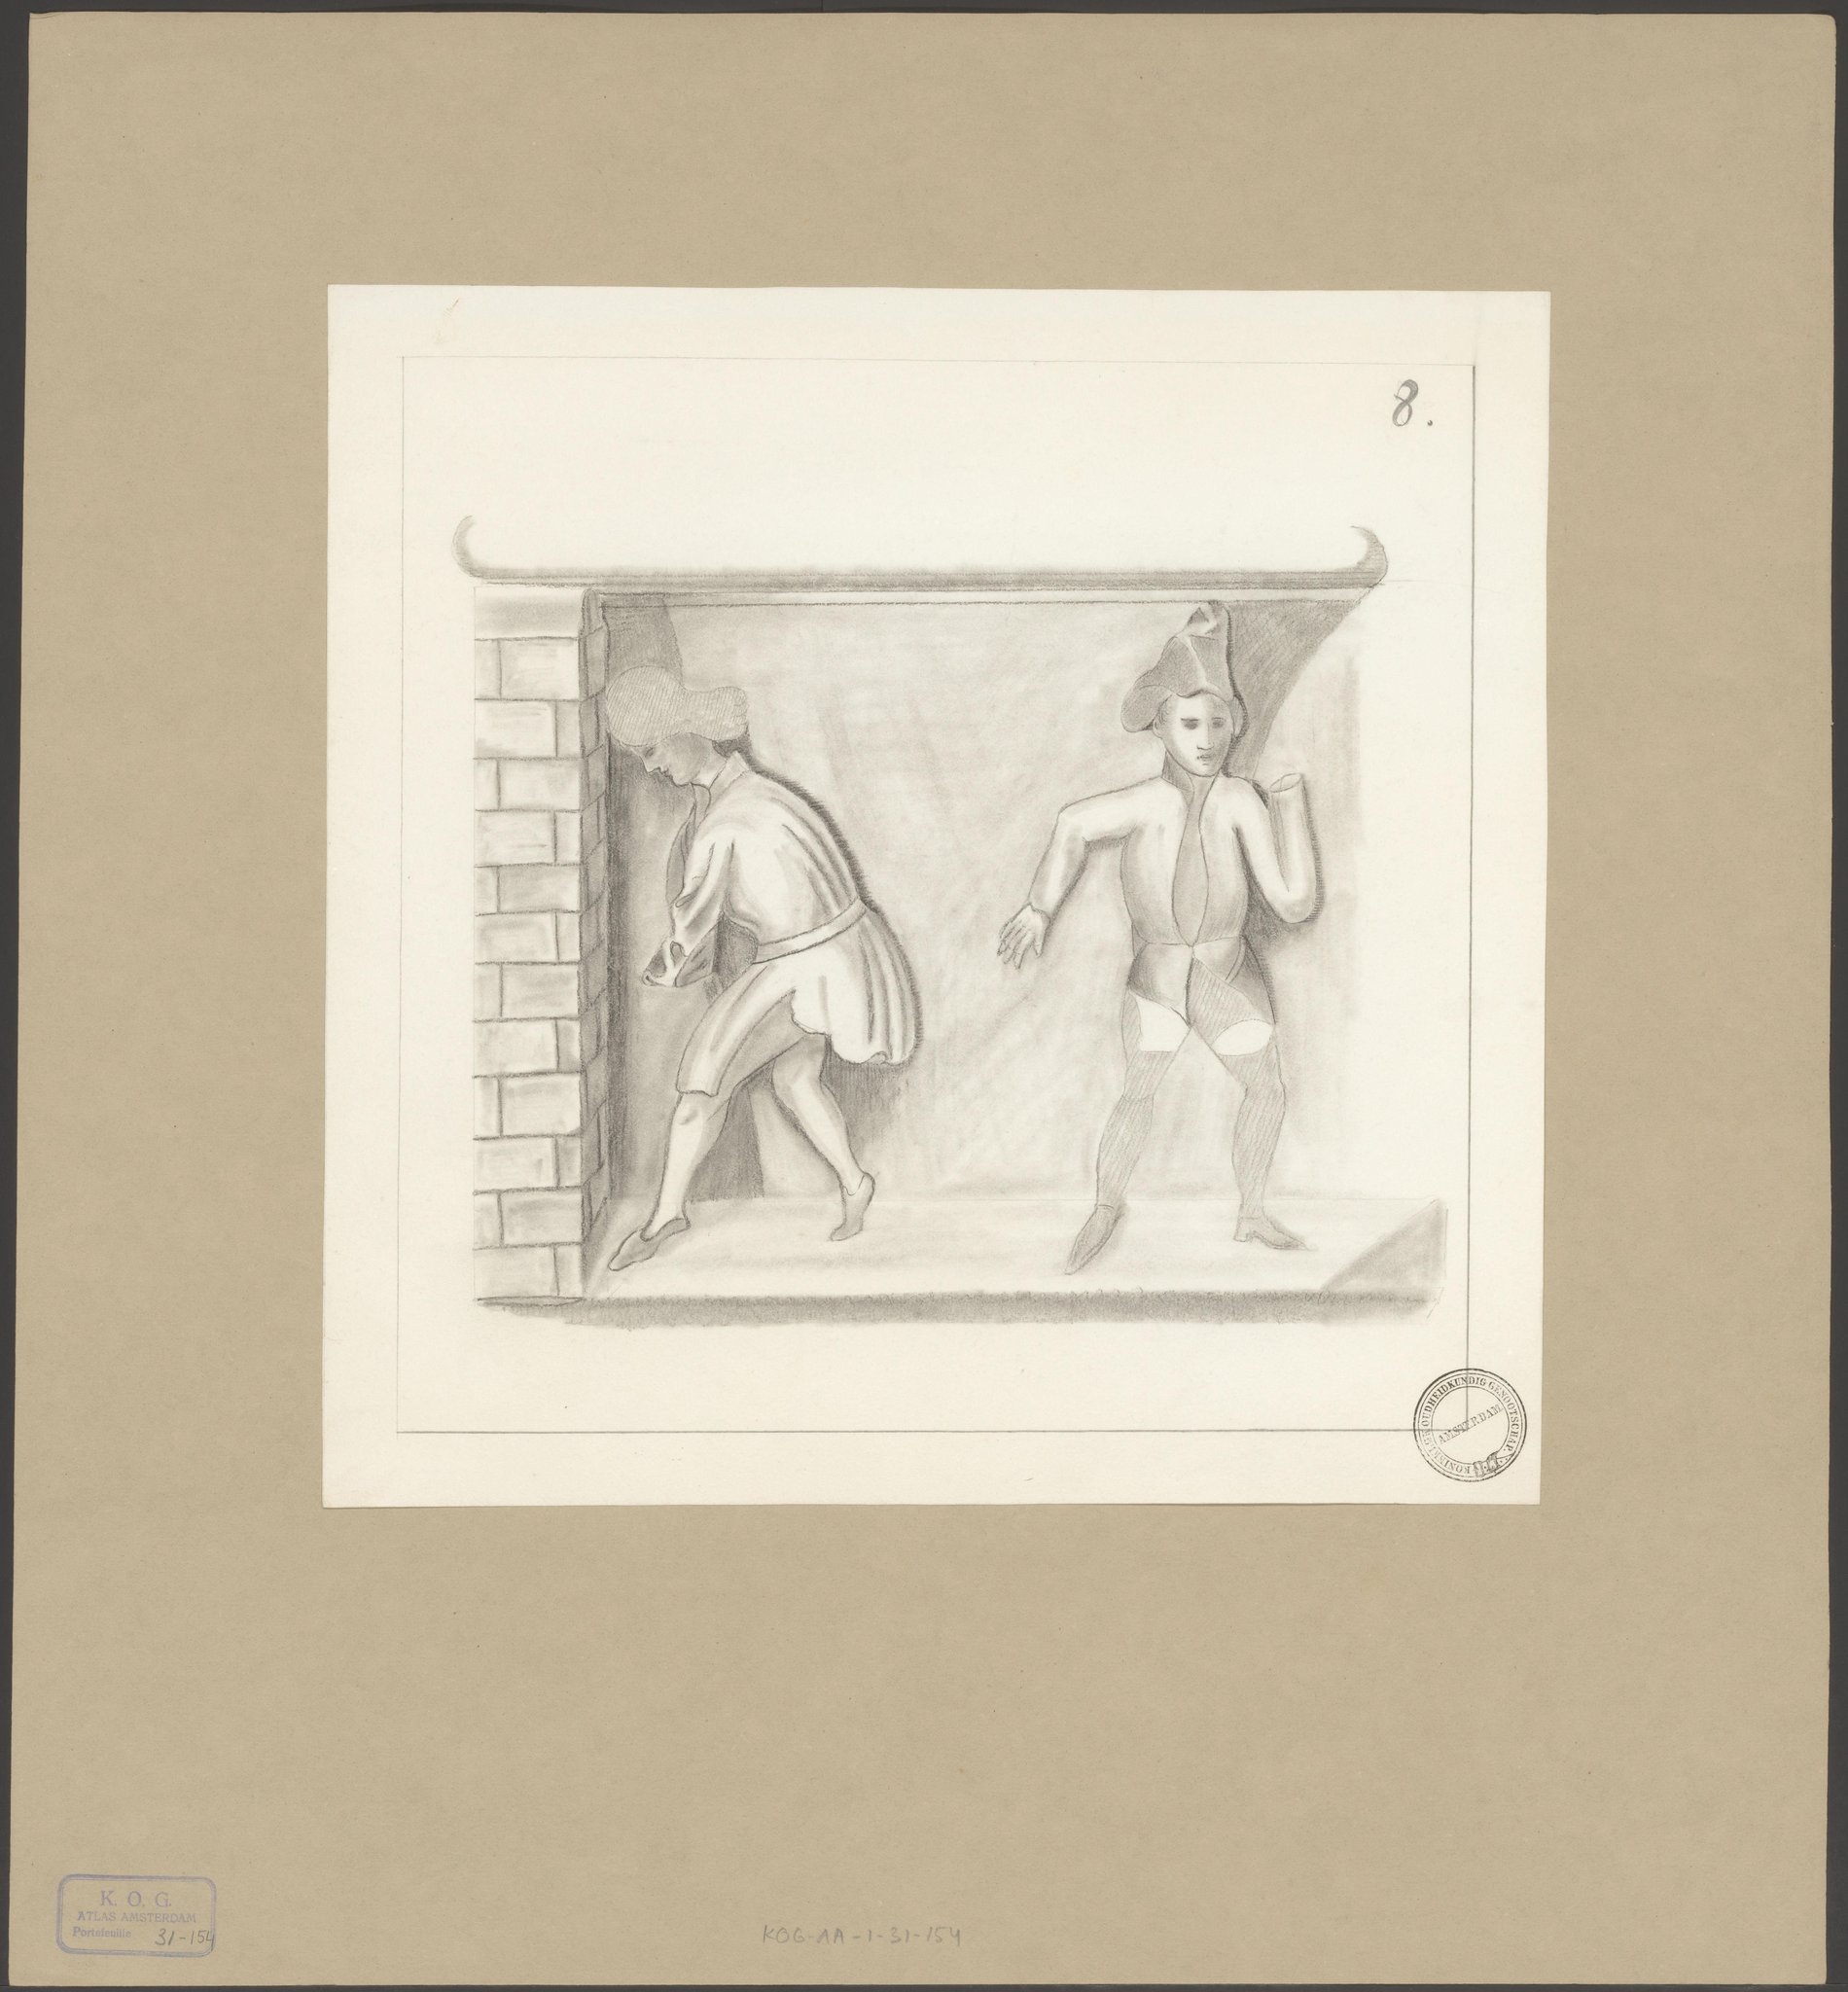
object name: print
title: Misericorde in de Oude Kerk te Amsterdam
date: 1880-1929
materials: paper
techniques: lithograph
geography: amsterdam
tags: misericords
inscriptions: collector's mark: ‘31-154’ Lugt 1641b, collector's mark: ‘Koninklijk Oudheidkundig Genootschap / Amsterdam’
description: Links een man die zijn hoofd tegen een bakstenen muur stoot, rechts een man die zijn arm ophoudt. Rechtsboven genummerd: 8. Onderwerpsrubriek binnen de Atlas Amsterdam: Kerkwezen: Hervormde Gemeente: Oude Kerk, koorgestoelte.